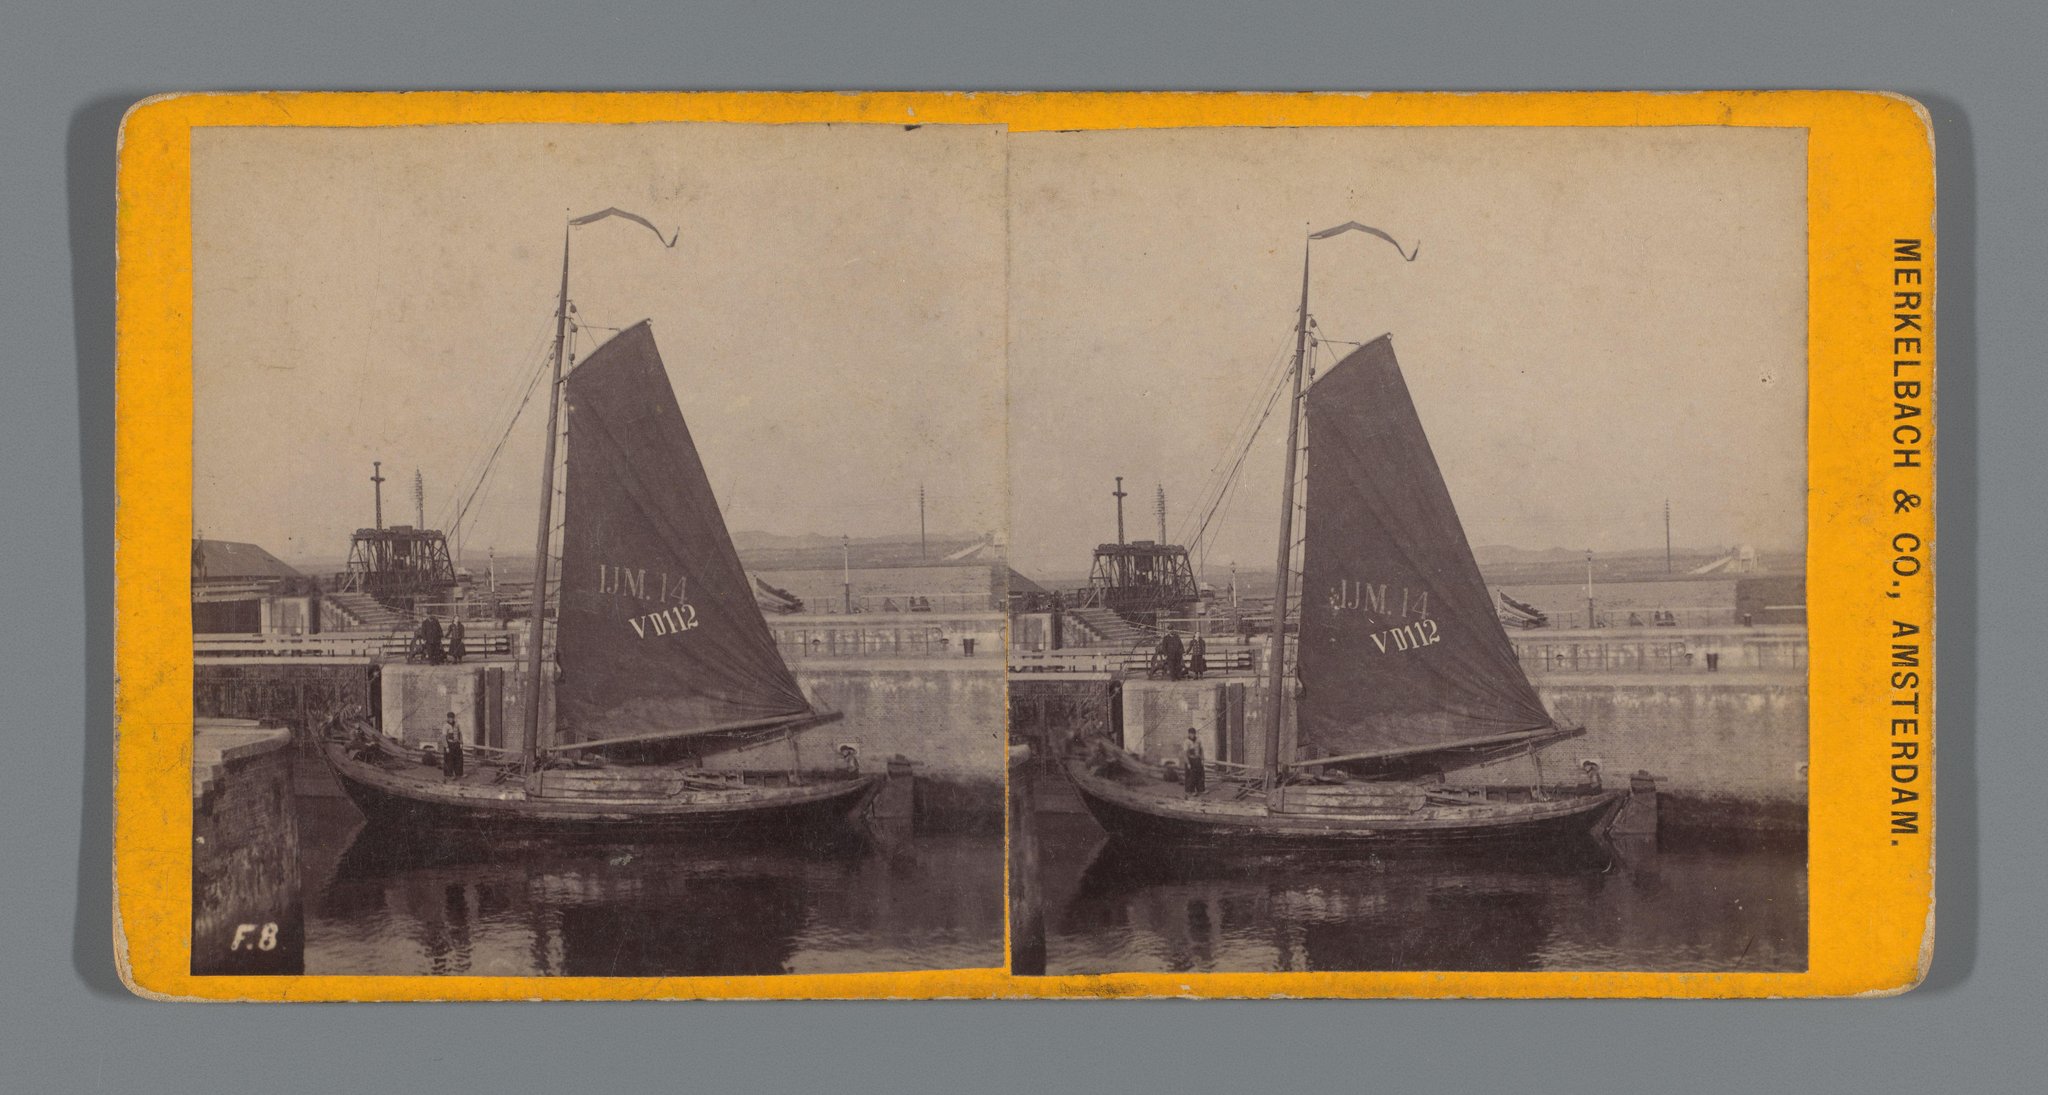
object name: stereograph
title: Aardrijkskundige Beeldengalerij, verzameld door M.J. Broekhuijsen, Hoofd eener school te Amsterdam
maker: martien johan broekhuijsen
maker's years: 1871-1956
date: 1905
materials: photographic support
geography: amsterdam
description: Onderdeel van een groep van 52 stereofoto's gebruikt in het lager onderwijs als aanvulling op schoolplaten. De gehele reeks bestond uit 274 nummers in 10 categorieën (A t/m K).